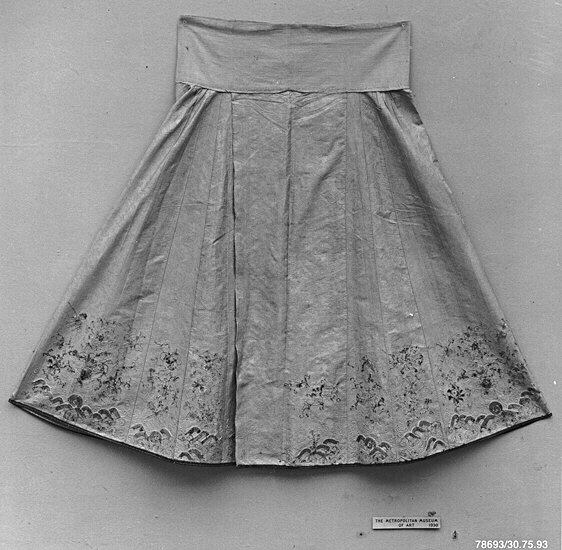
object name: skirt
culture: chinese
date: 1701-1800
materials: silk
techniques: damask, embroidery